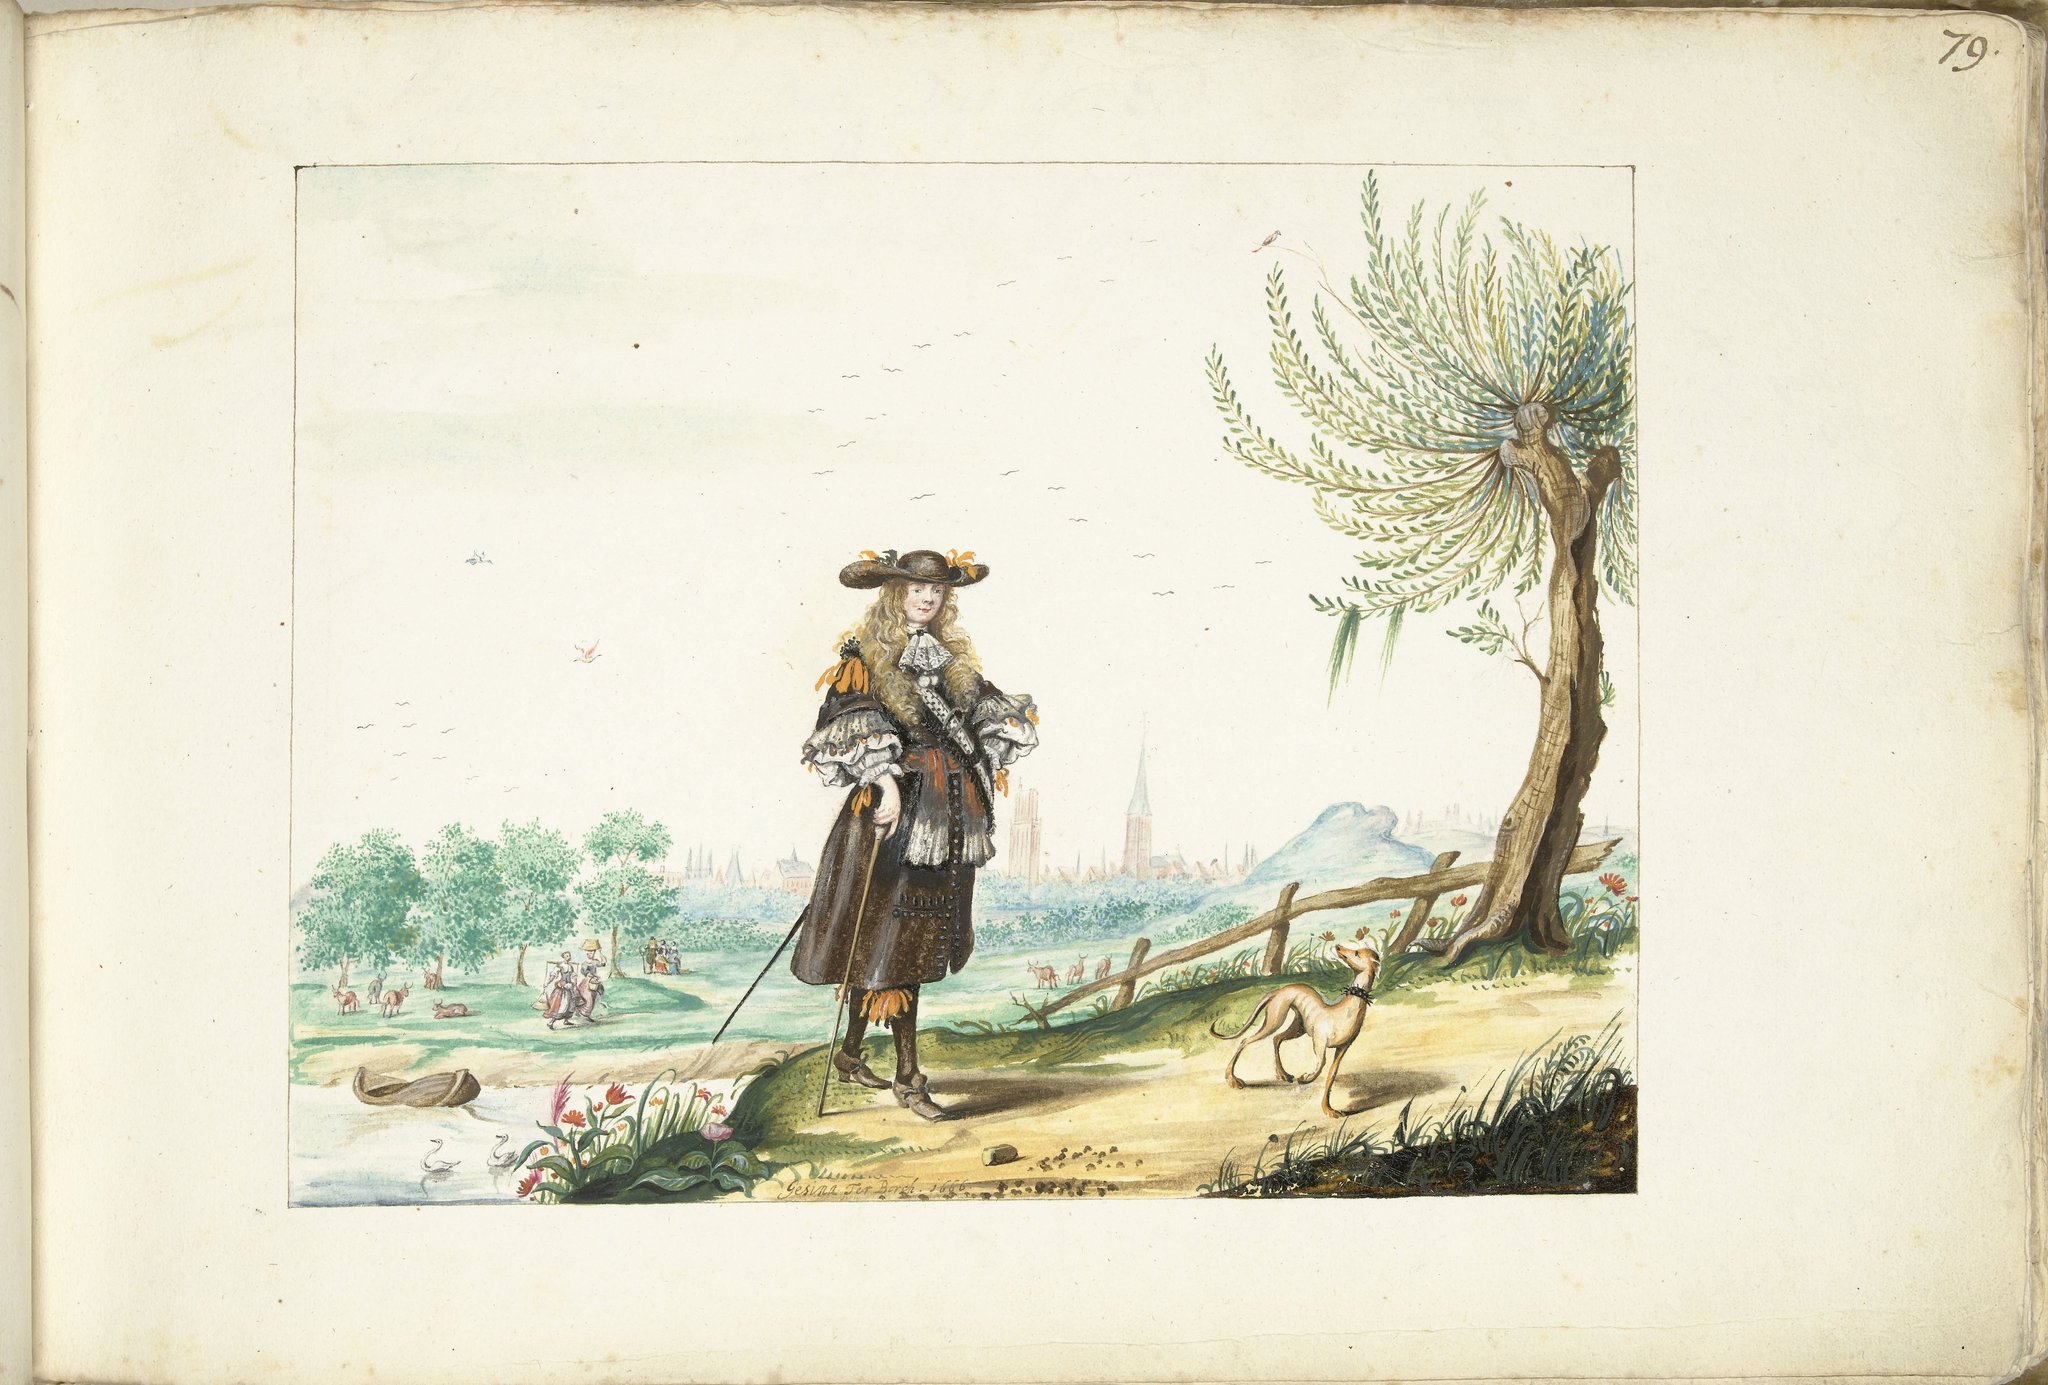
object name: drawing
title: Moses ter Borch op het platteland buiten Zwolle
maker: gesina ter borch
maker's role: draughtsman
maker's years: 1633-1690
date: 1667-1670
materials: paper, watercolor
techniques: brush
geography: zwolle